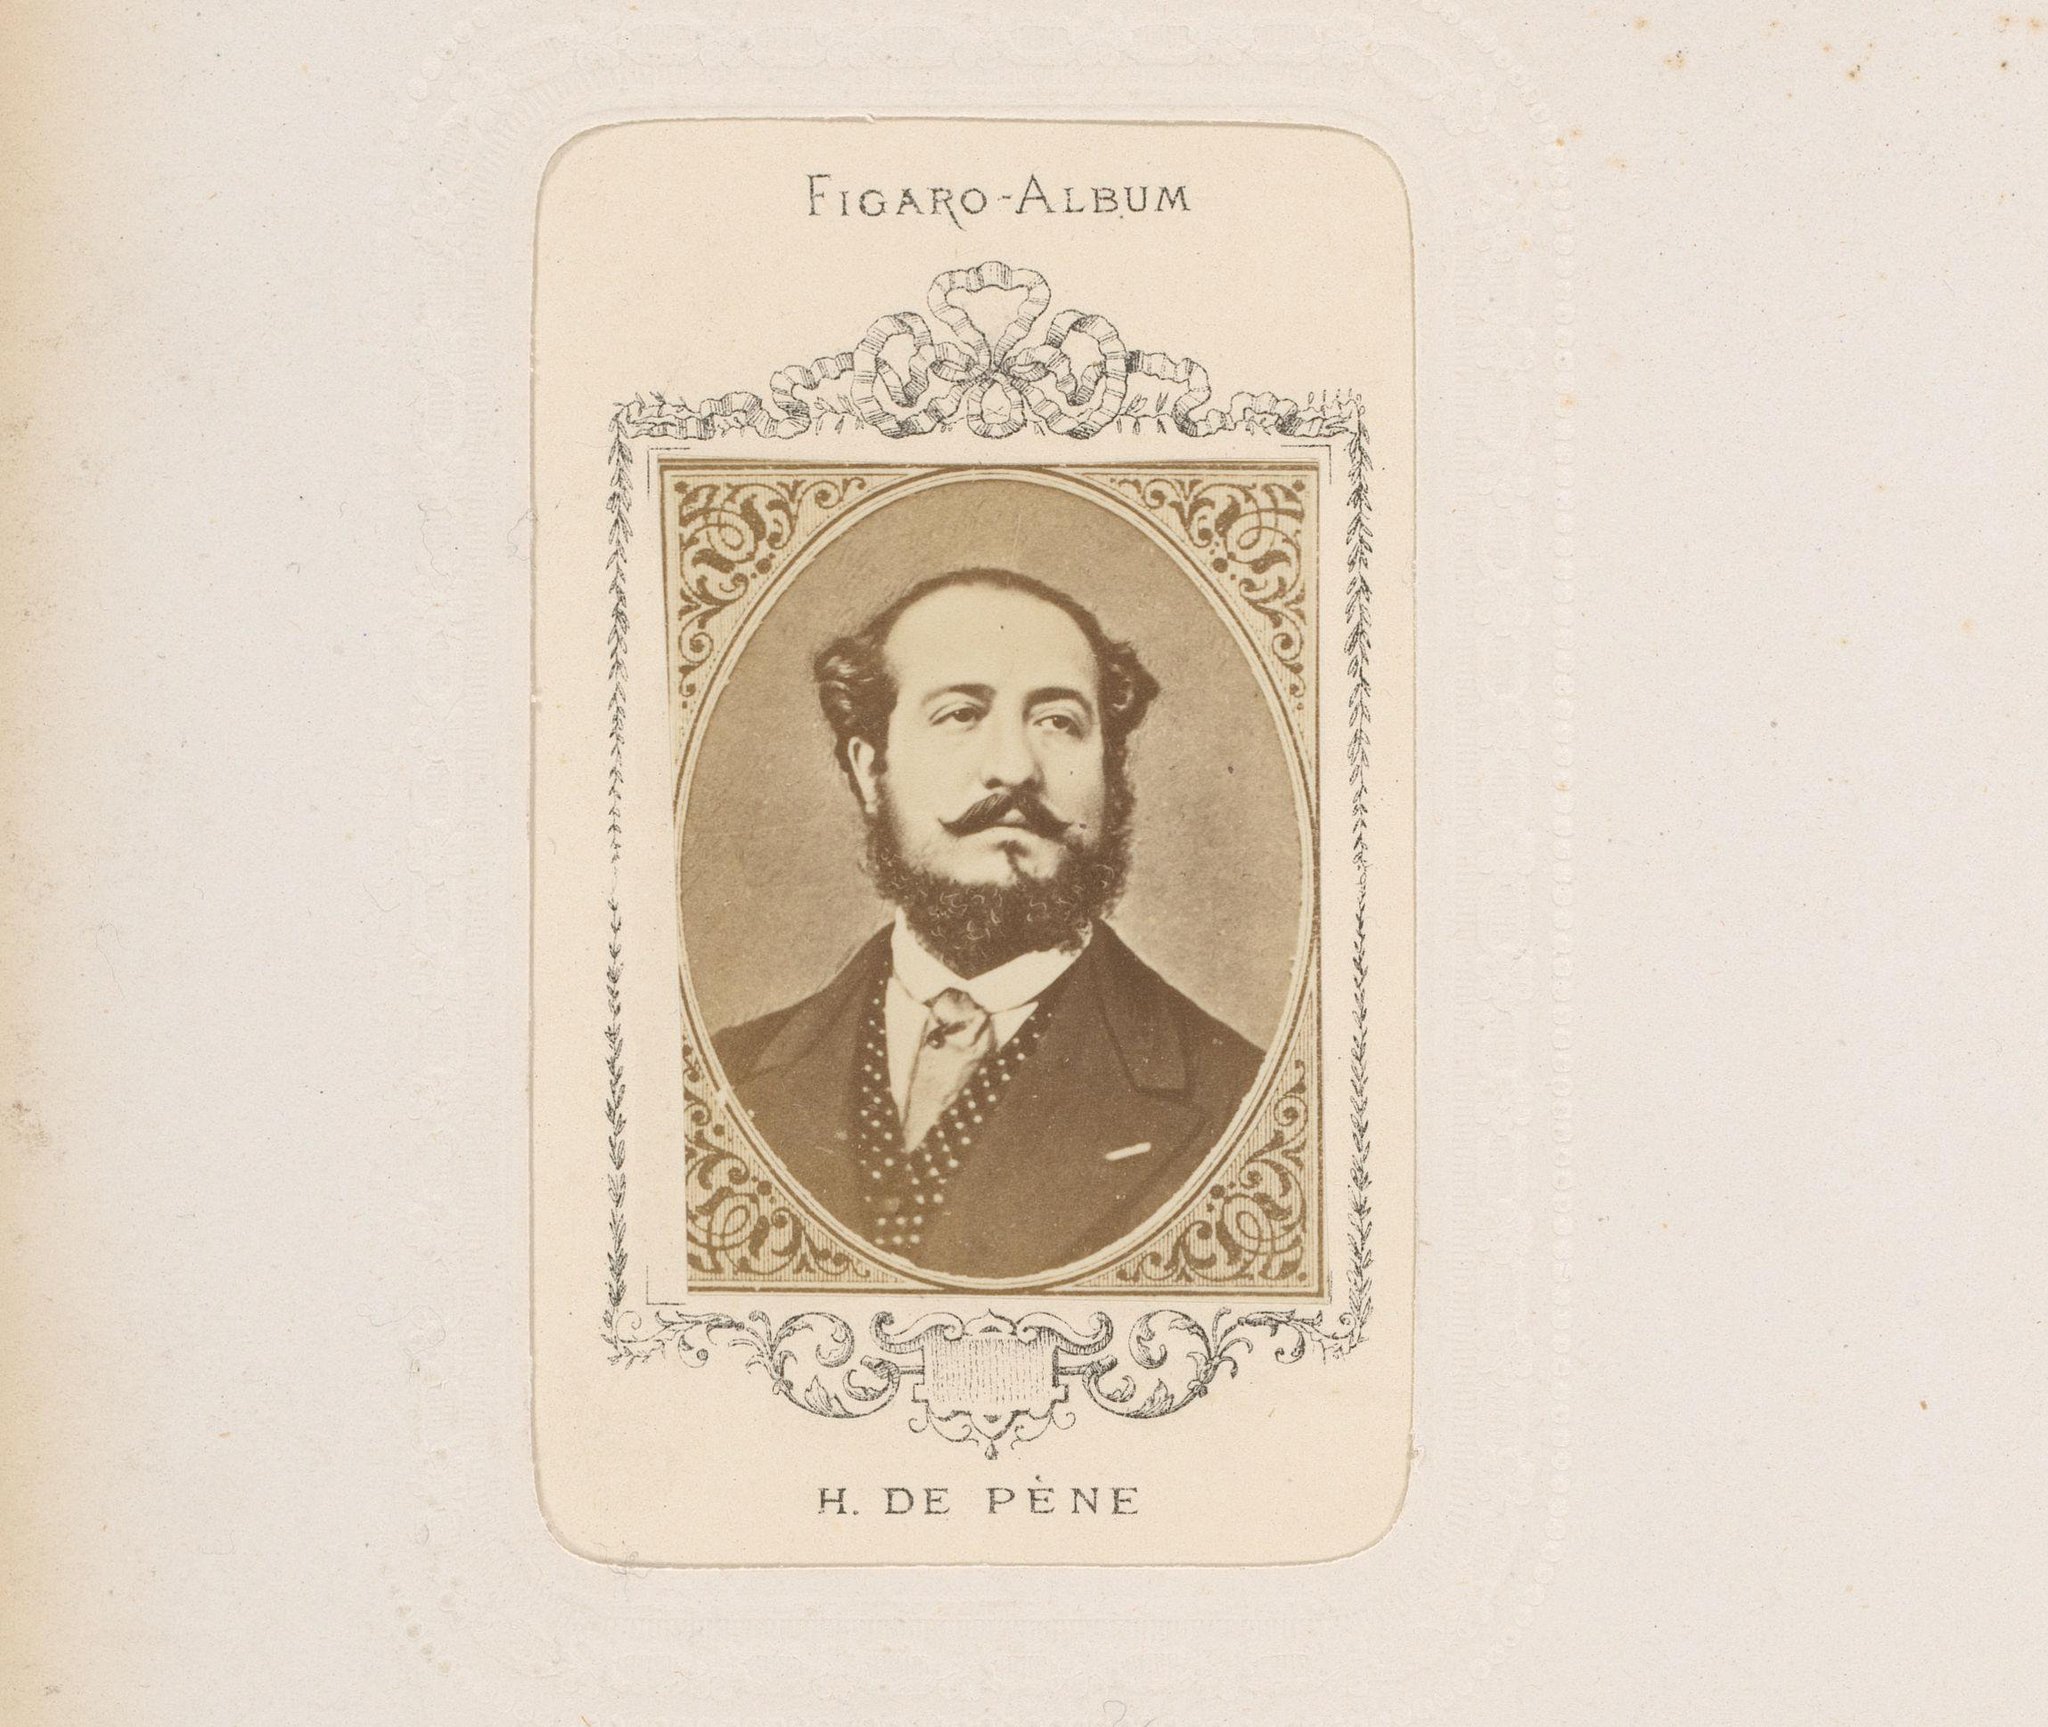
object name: photograph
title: Fotoreproductie van een portret van H. de Pène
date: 1860-1900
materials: cardboard, photographic support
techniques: albumen print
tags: historical persons, beard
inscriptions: inscription: ‘Figaro-Album/ H. de Pène/ Liébert Phot.’